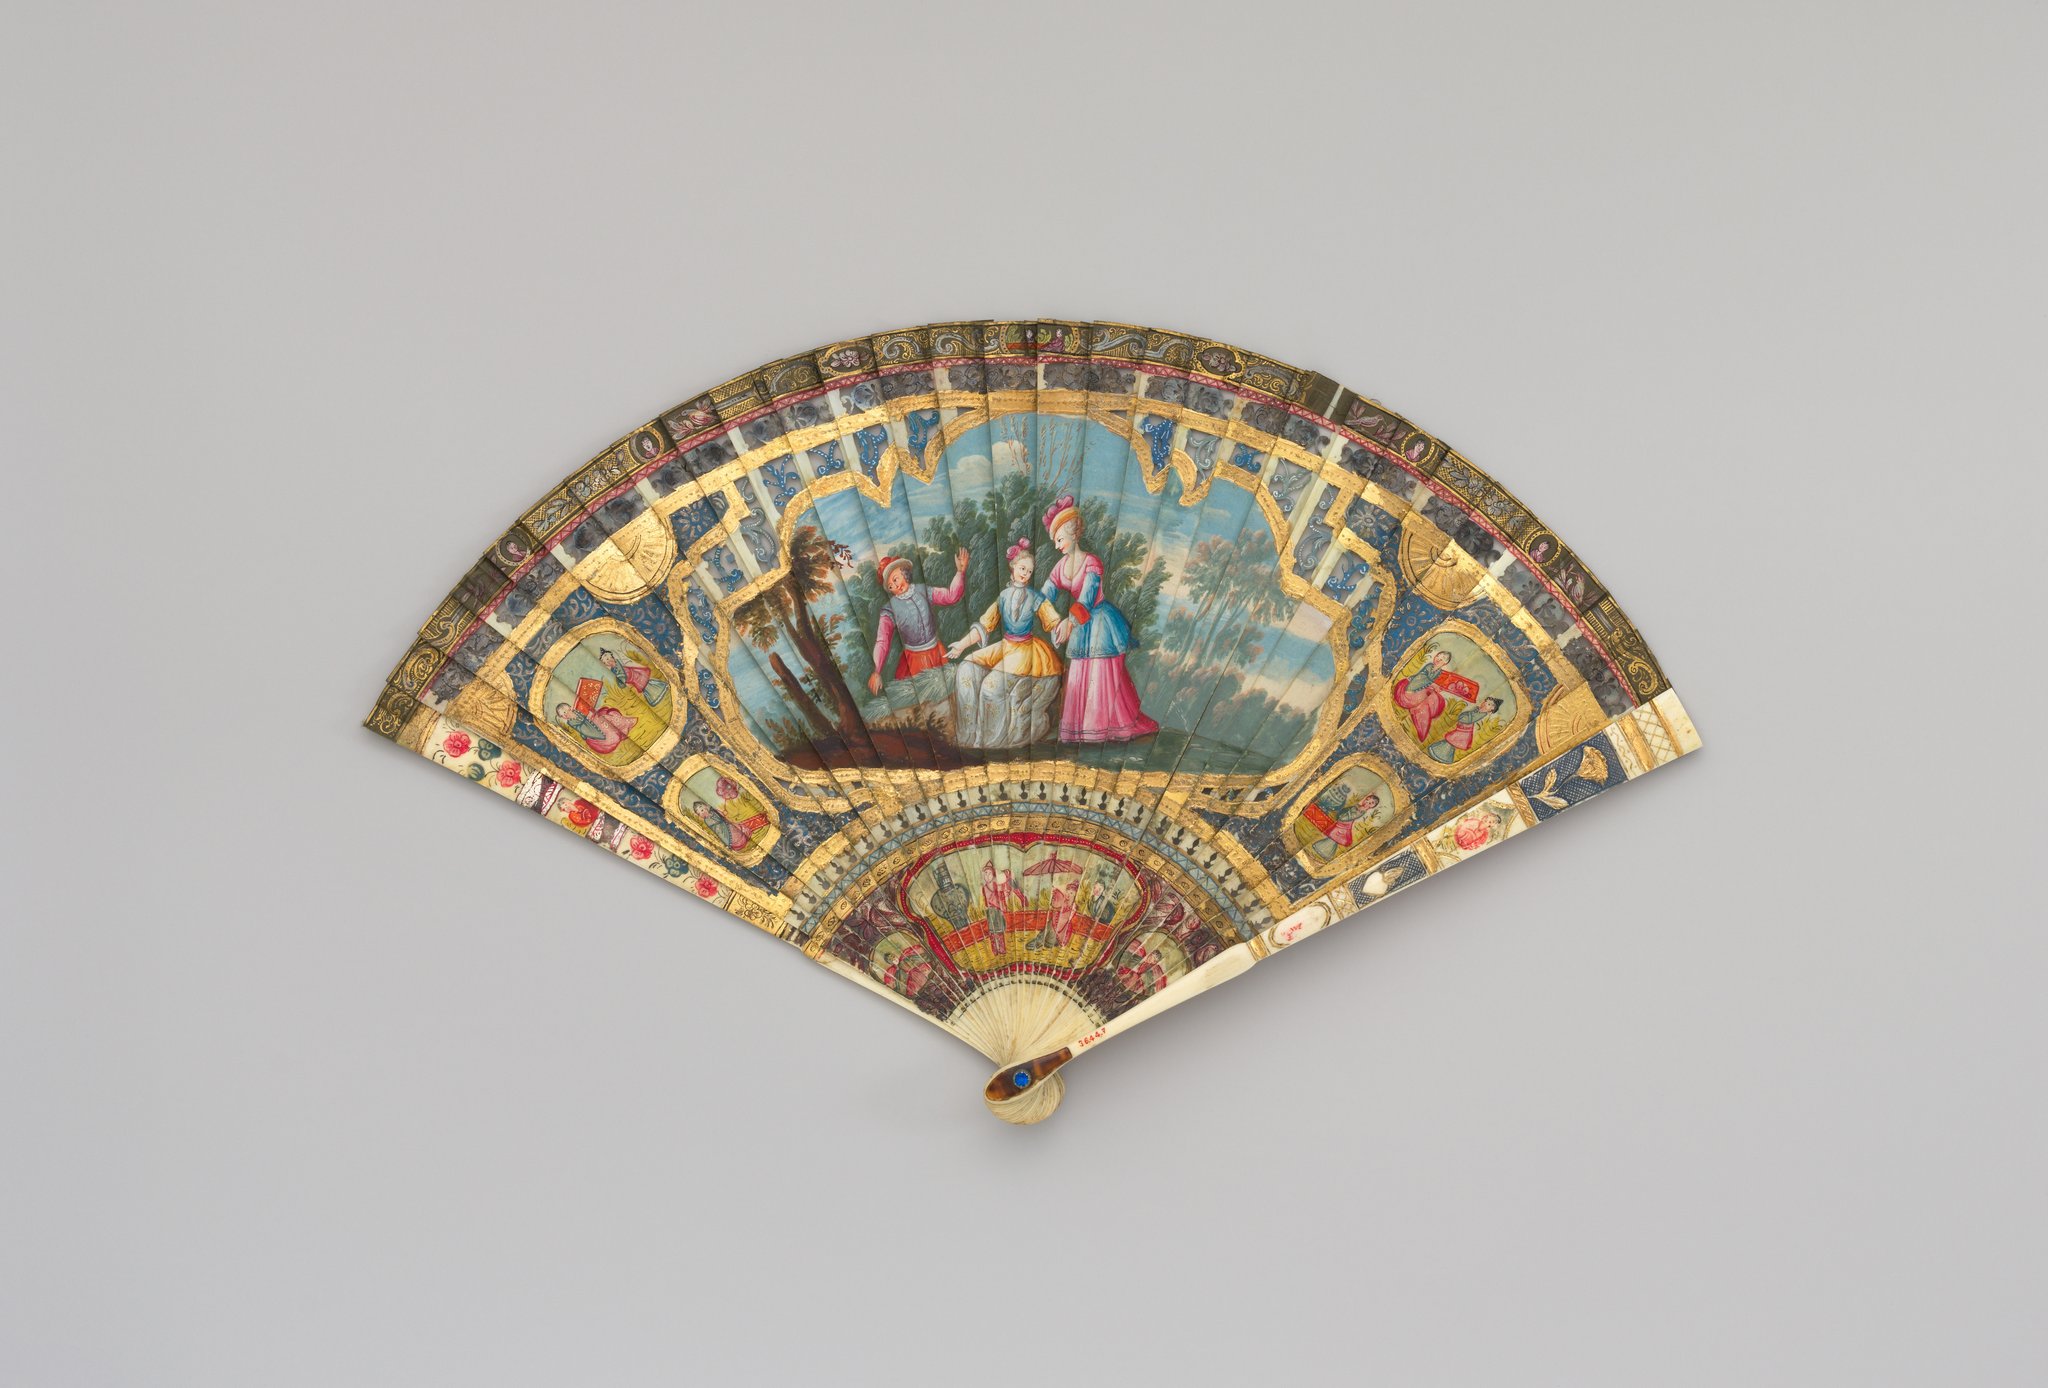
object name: fan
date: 1701-1750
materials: ivory